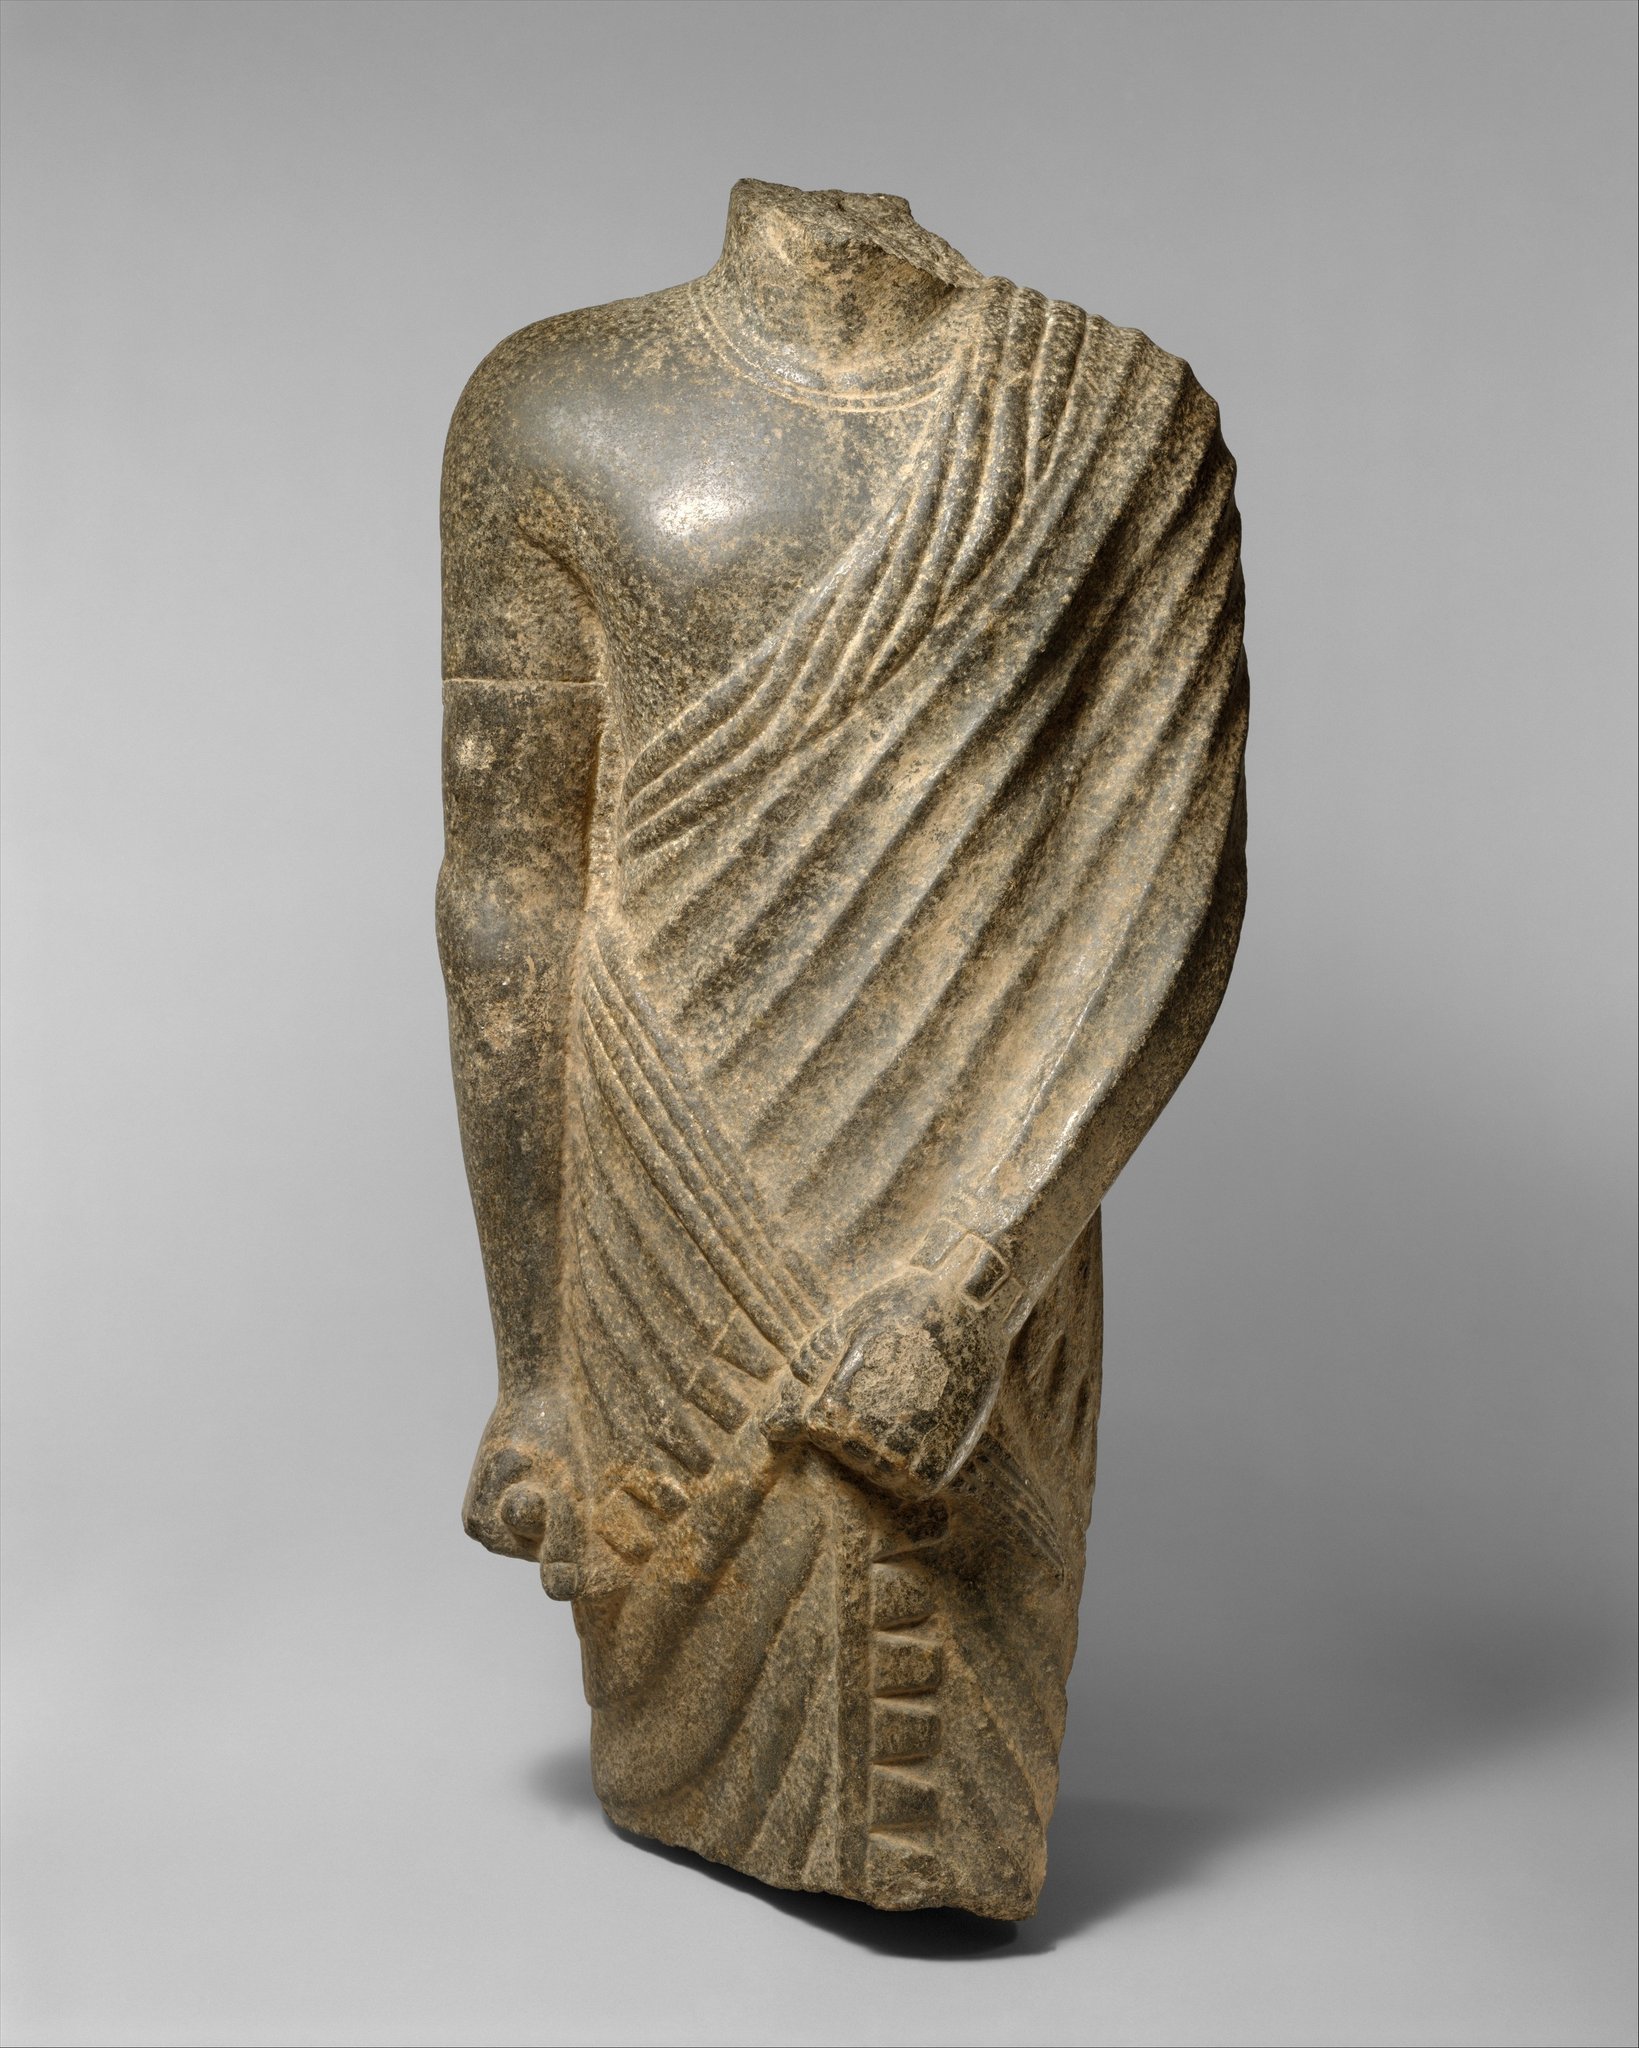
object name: statue, draped male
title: Torso of a Striding Draped Male Figure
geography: egypt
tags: men